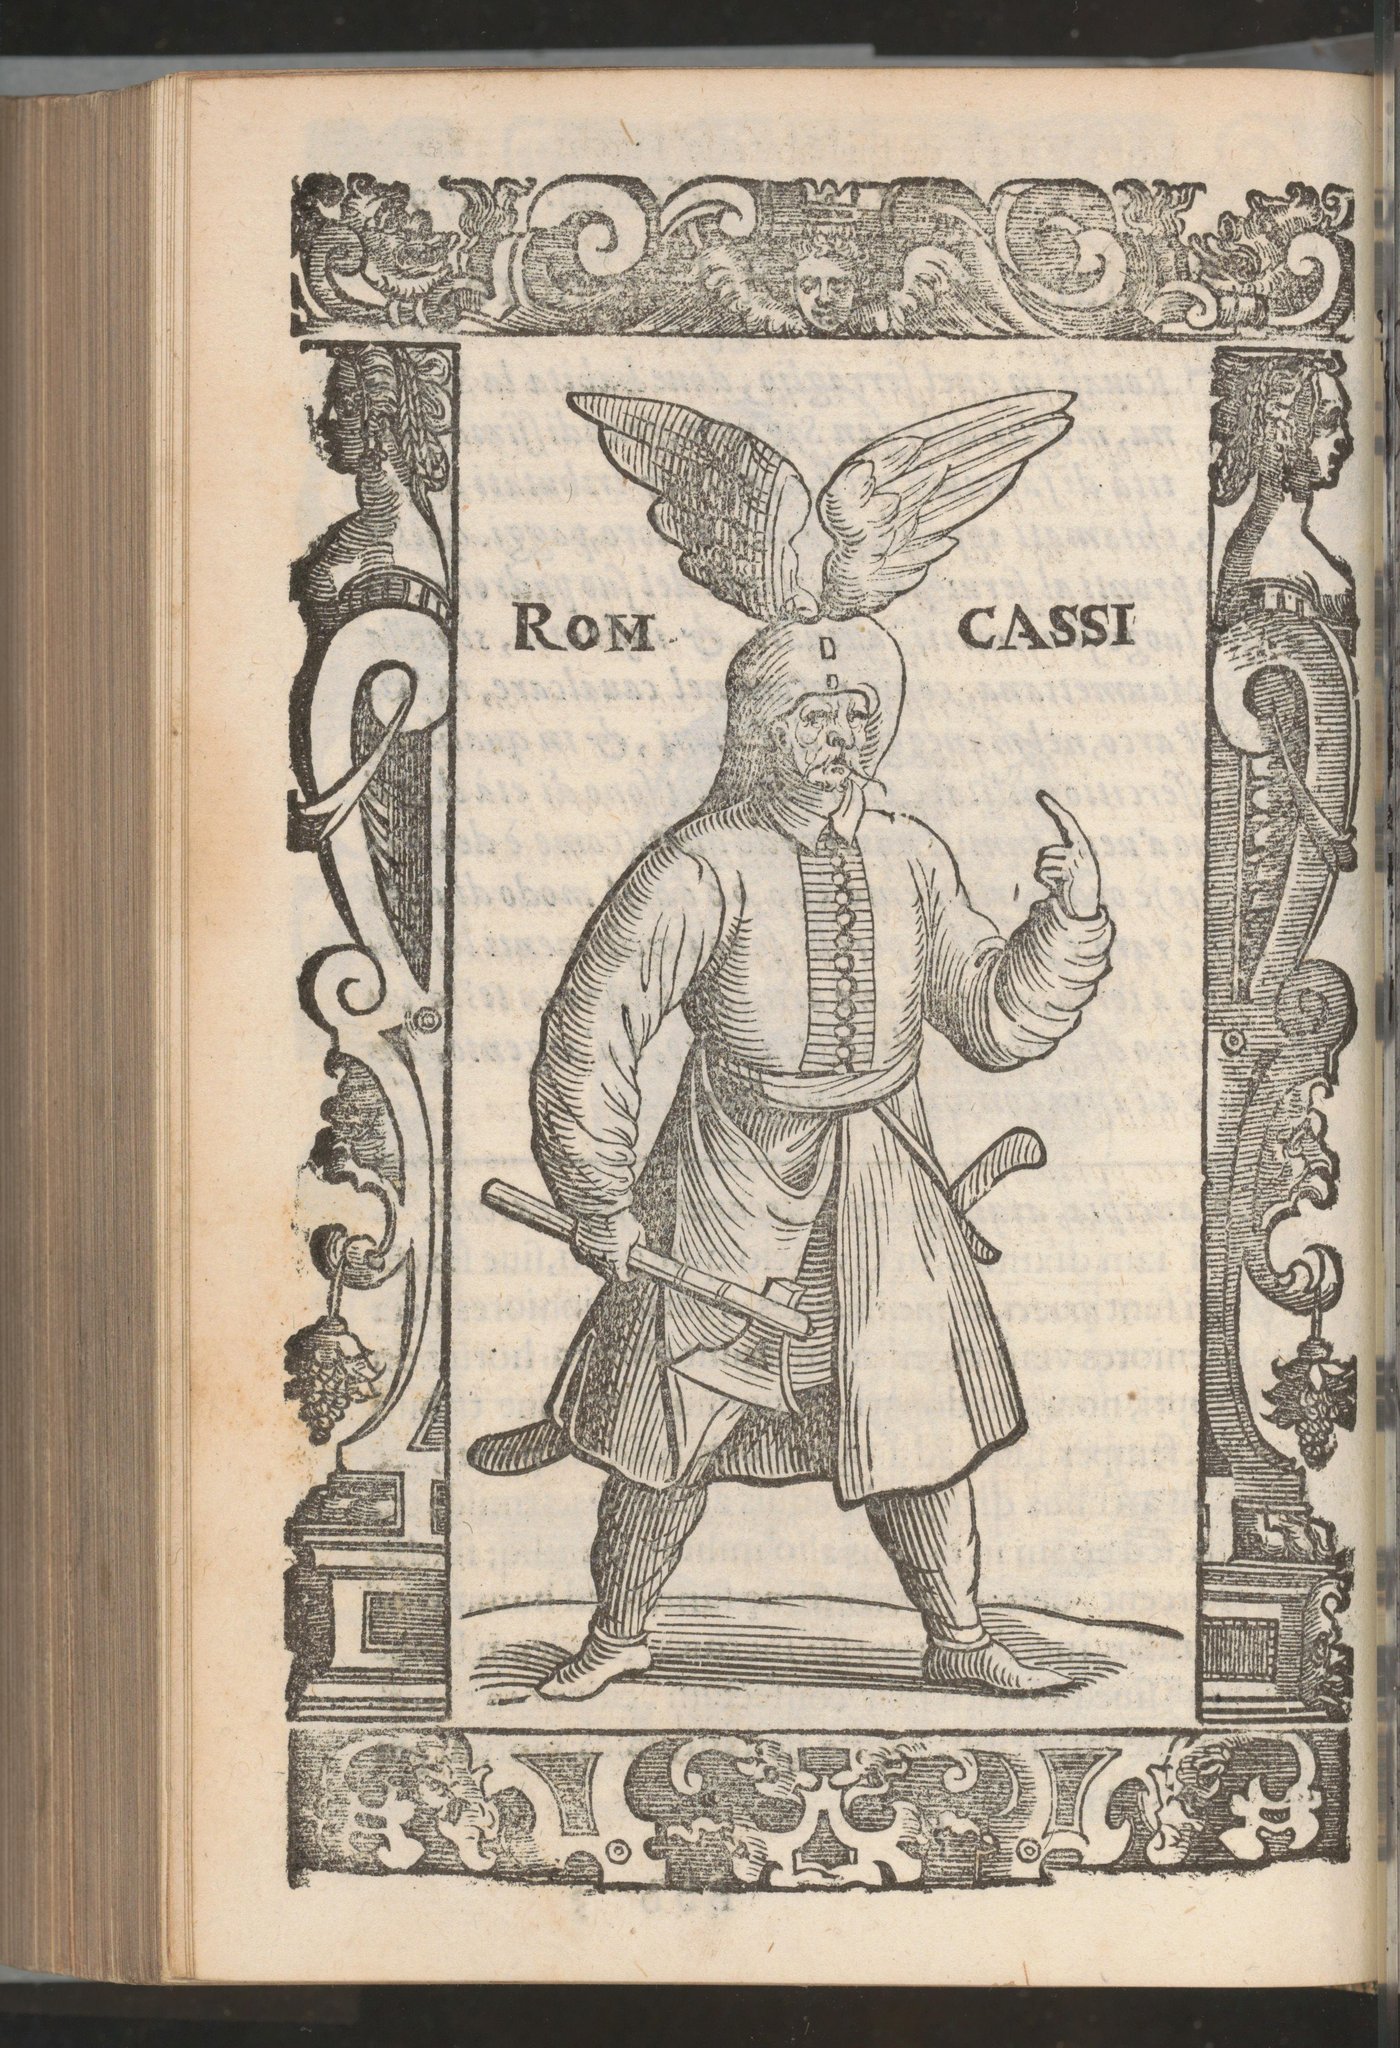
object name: costume print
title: Romcassi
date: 1598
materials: paper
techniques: woodcut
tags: fashion plates